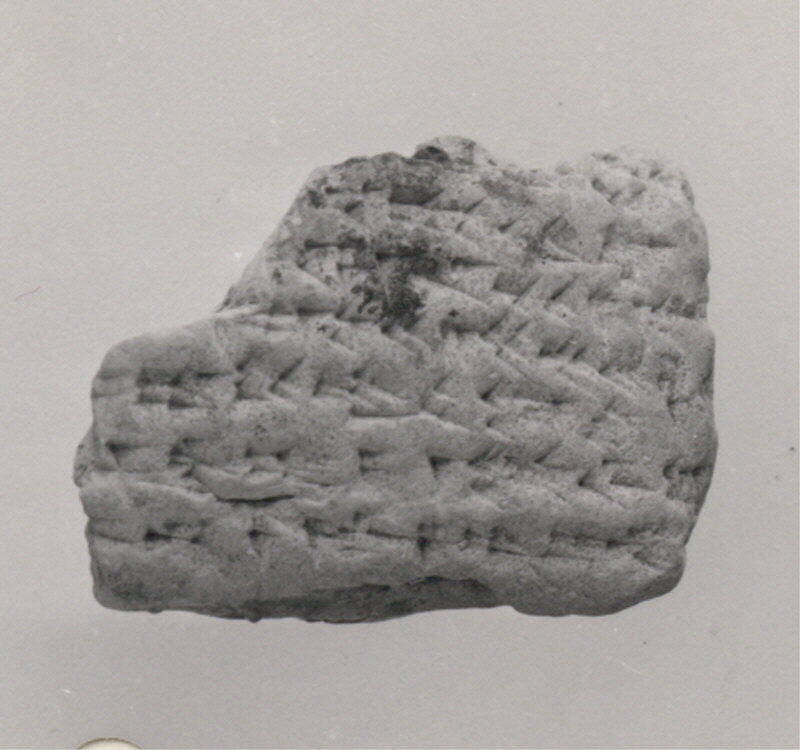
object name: cuneiform tablet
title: Cuneiform tablet: promissory note for barley, Esagilaya archive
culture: babylonian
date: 568 BCE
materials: clay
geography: mesopotamia